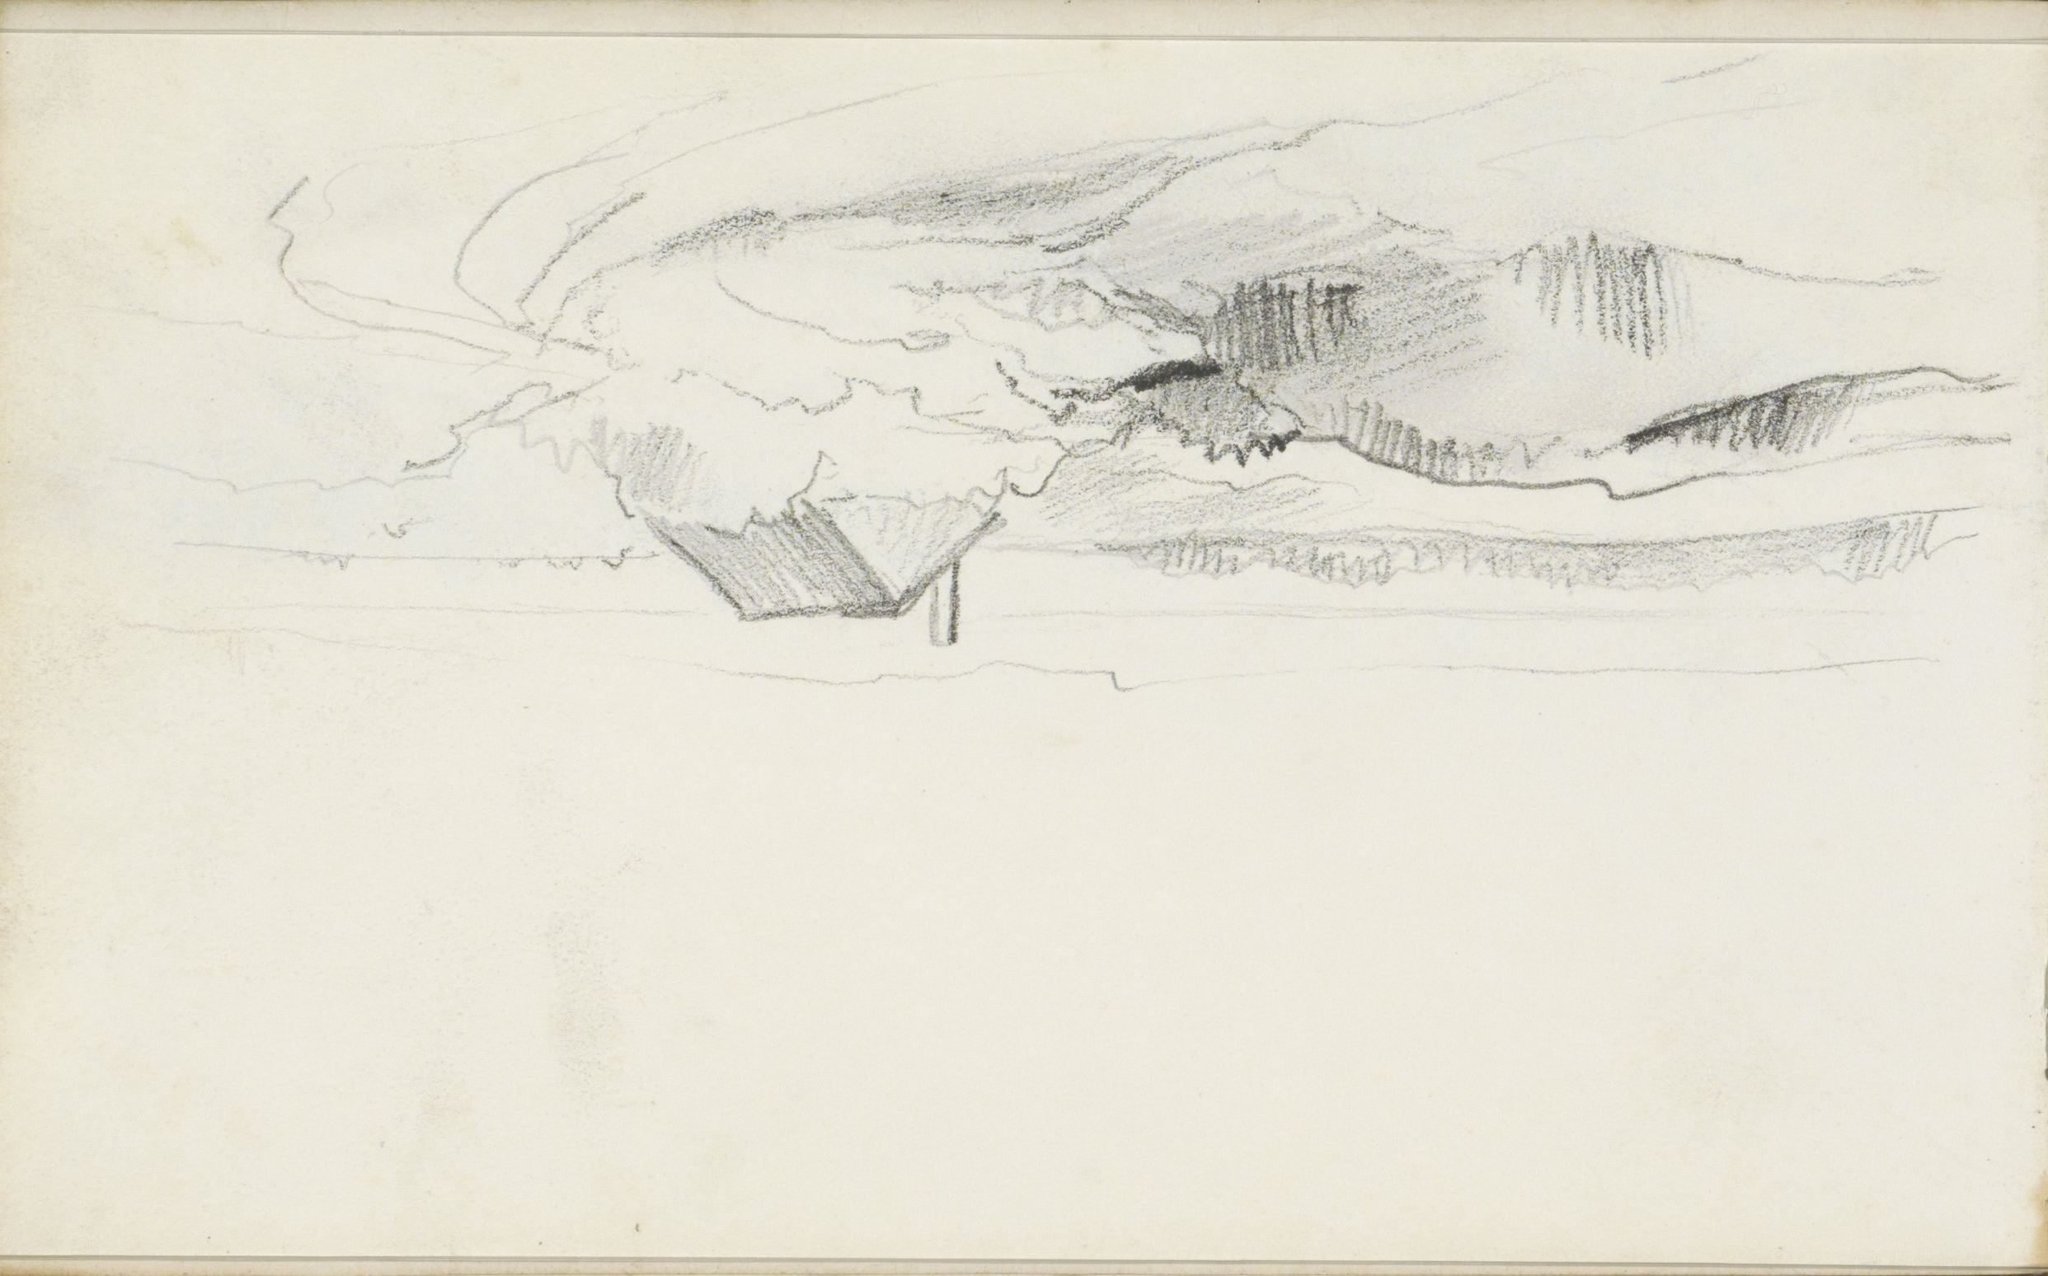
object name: sketchbook leaf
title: Huis in een heuvellandschap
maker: johannes tavenraat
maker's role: draughtsman, painter, print maker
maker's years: 1809-1881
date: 1840-1841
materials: paper, pencil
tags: low hill country, rural housing, e.g. country-house, villa, cottage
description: Blad 36 verso uit een schetsboek met 41 bladen.